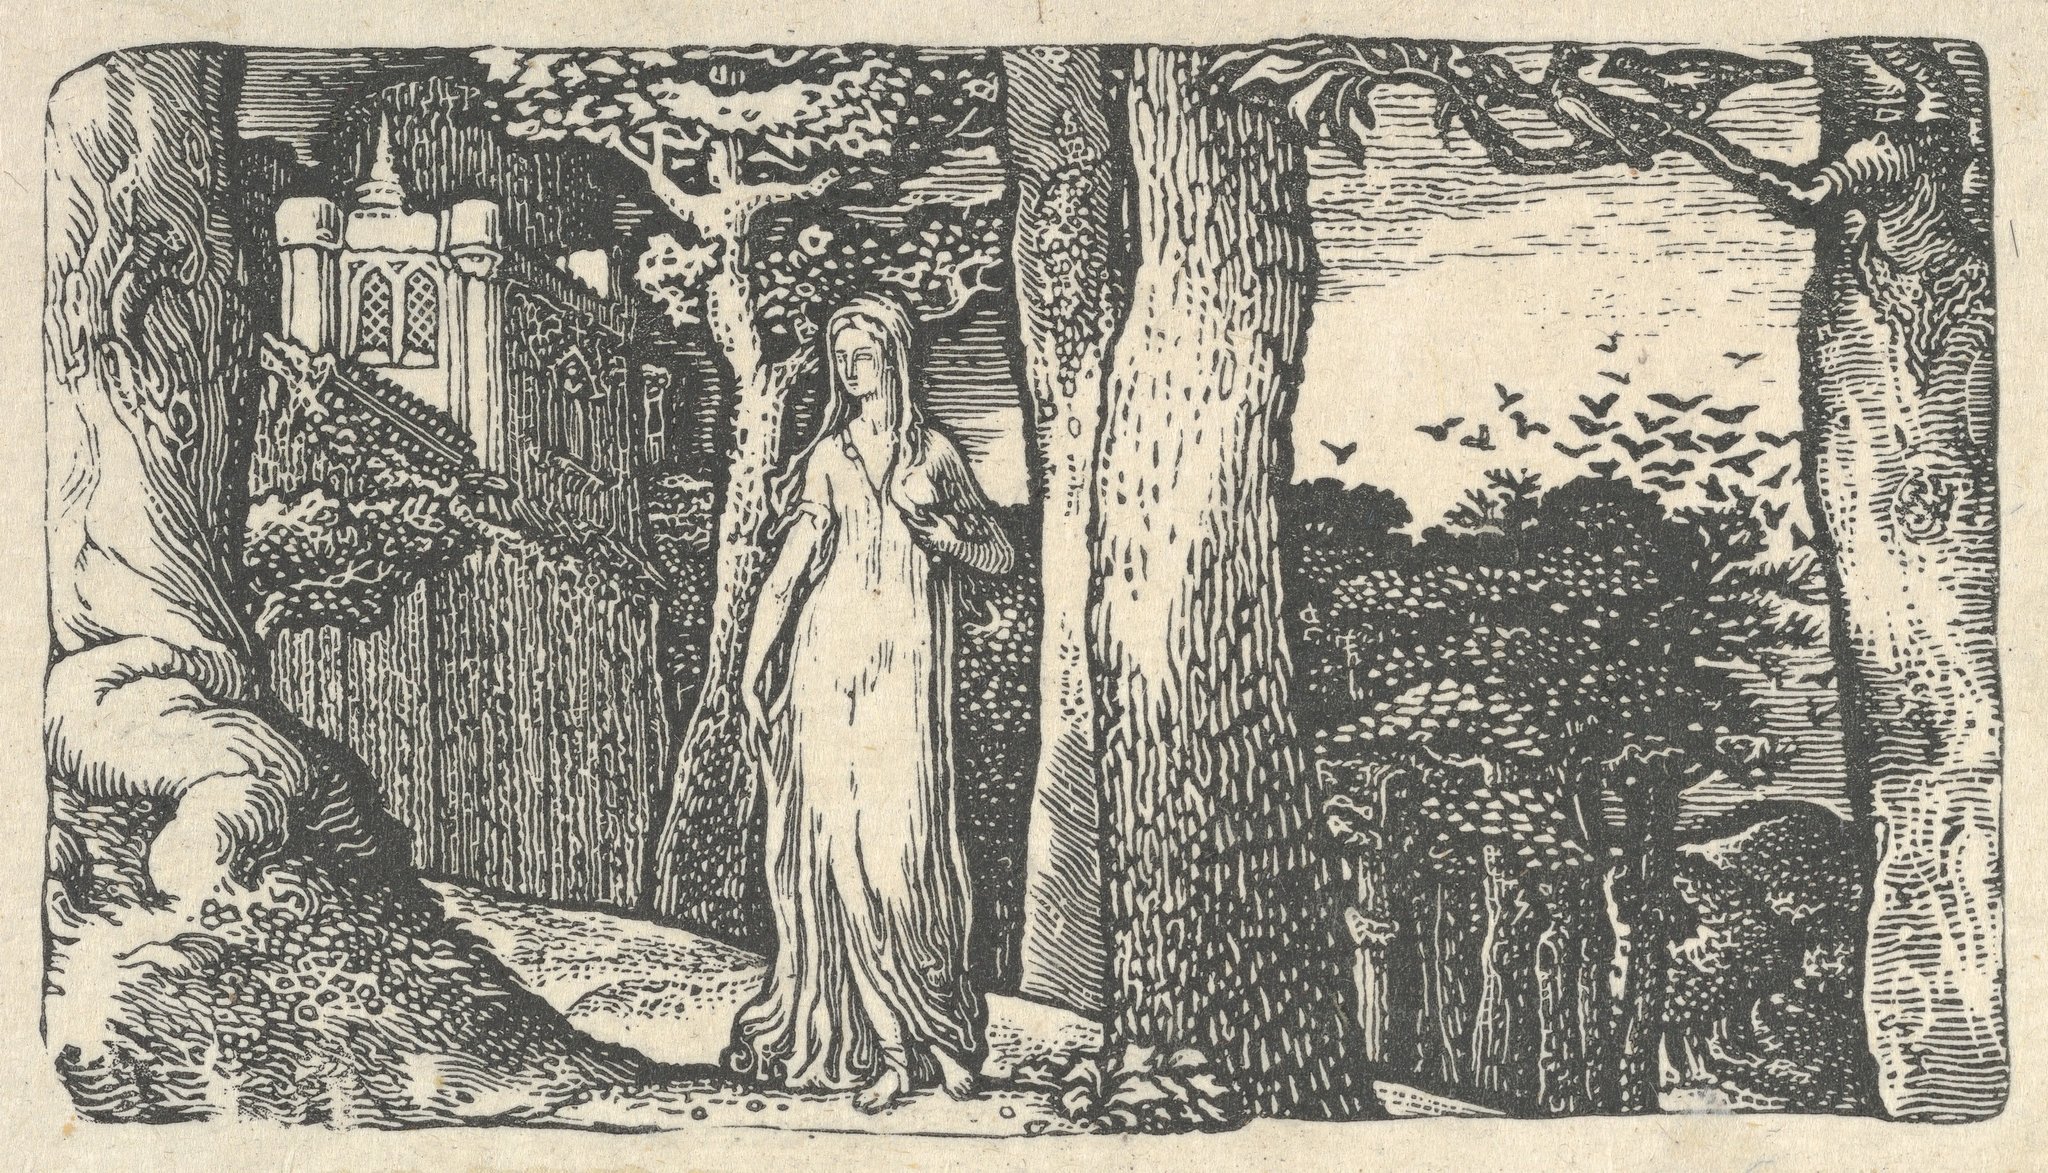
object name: print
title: Lady with the Rooks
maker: edward calvert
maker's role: artist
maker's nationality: british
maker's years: 1799-1883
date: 1829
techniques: engraving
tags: buildings,women,trees